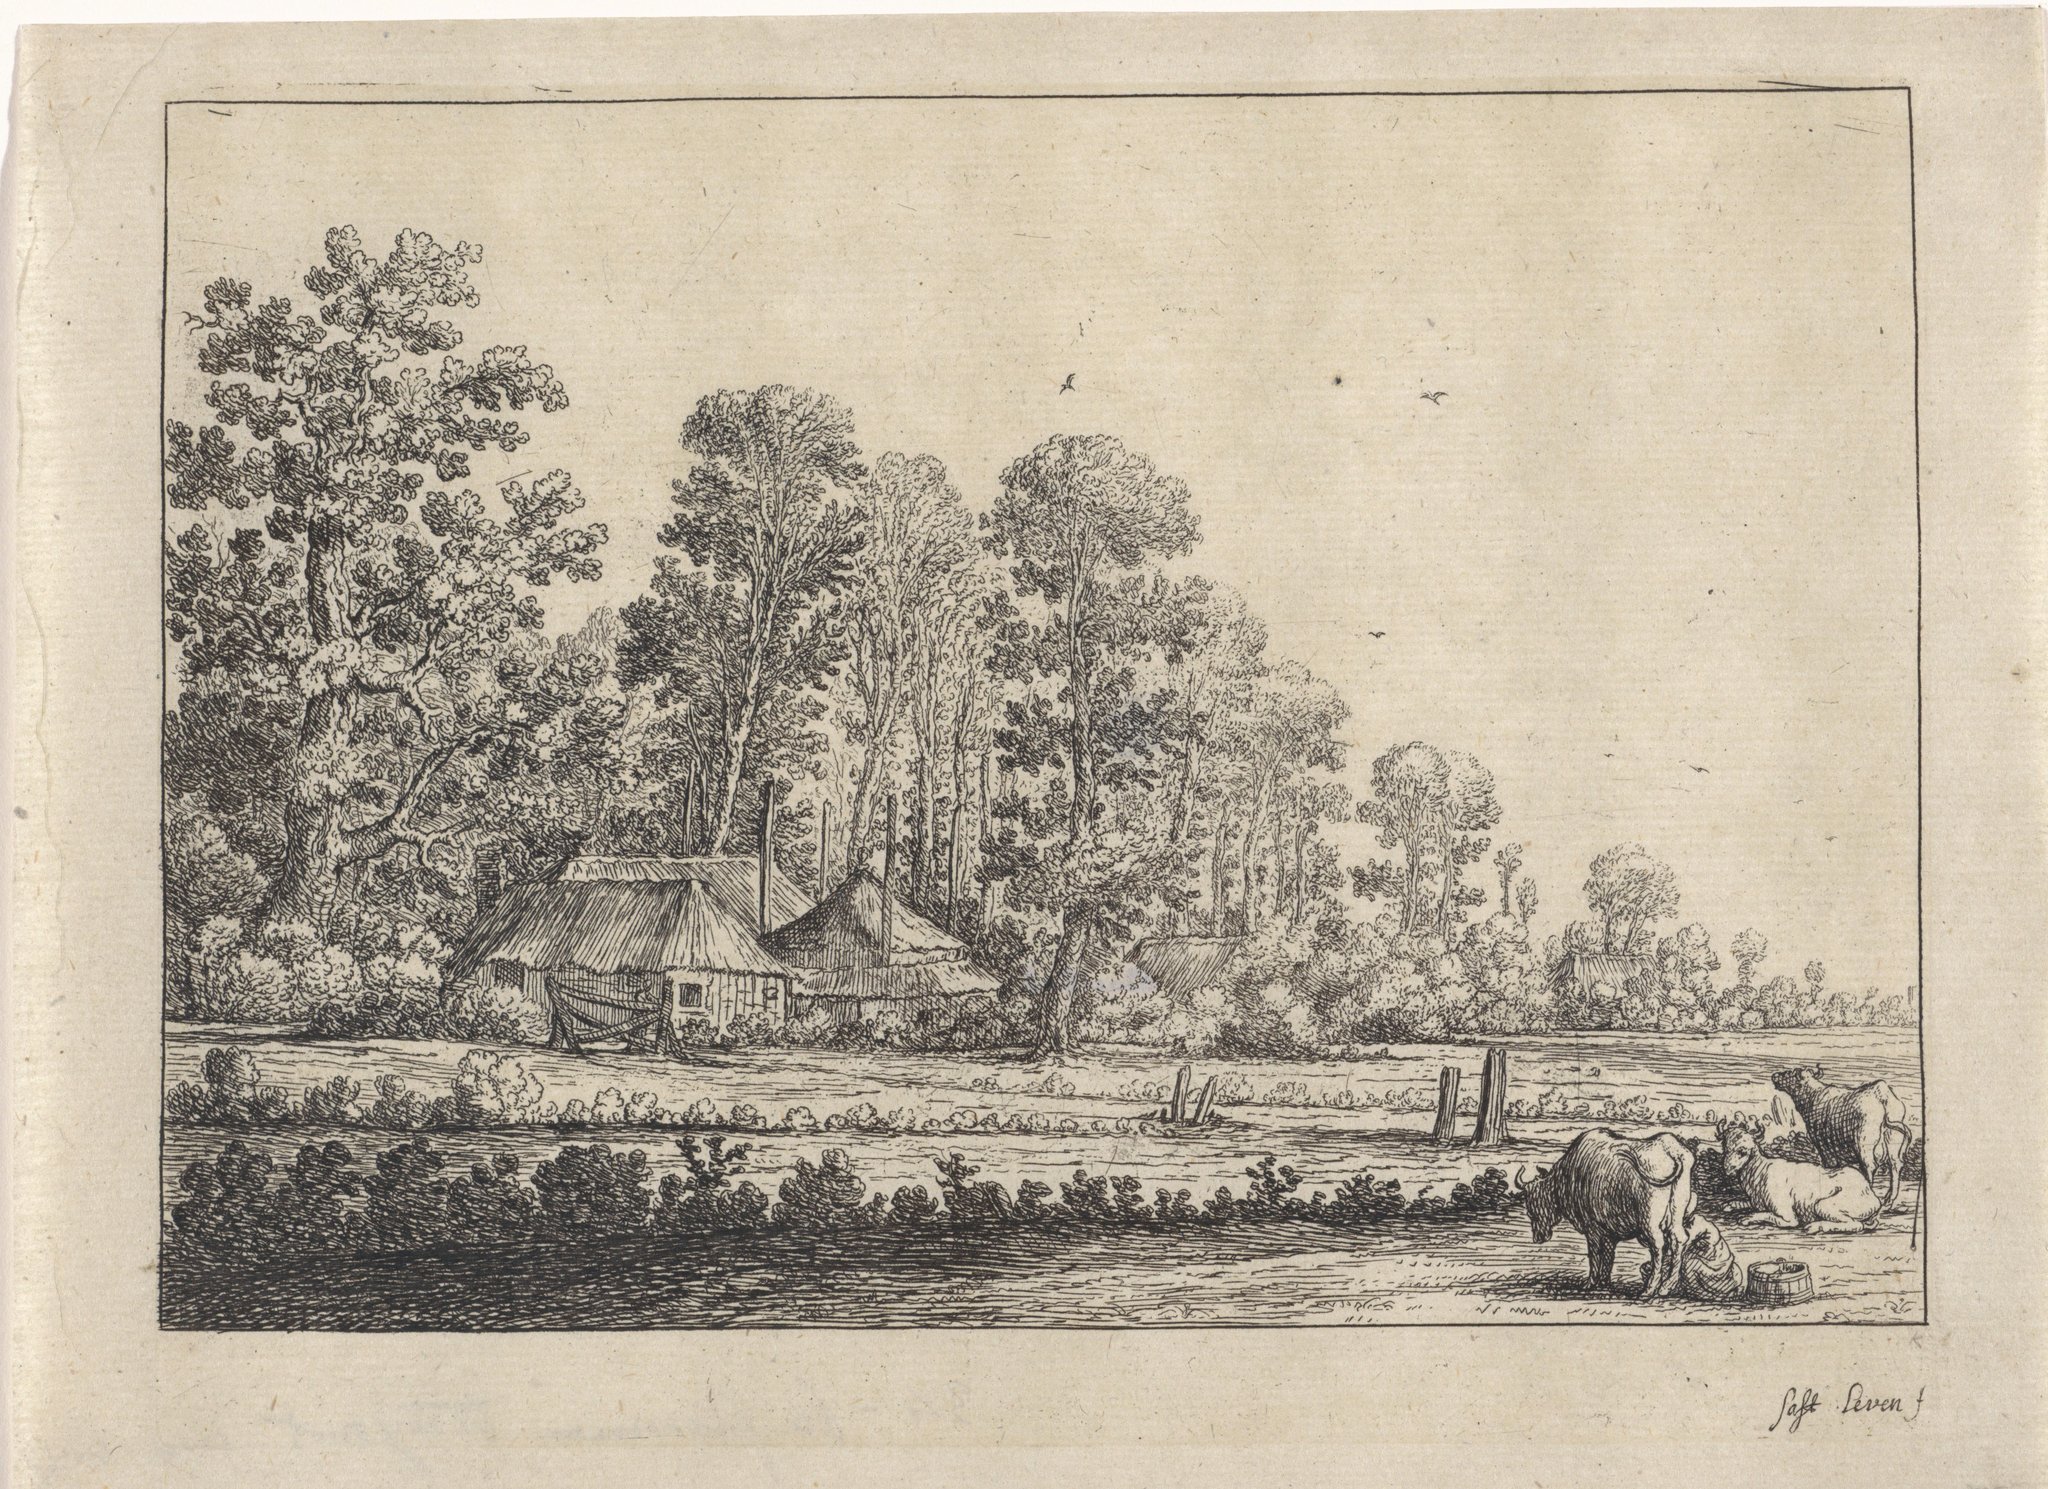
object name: print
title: Boerderij met koeienmelkster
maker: herman saftleven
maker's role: draughtsman, painter, print maker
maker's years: 1609-1685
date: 1626-1685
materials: paper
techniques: etching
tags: cow, river, bovine cattle, farm (building)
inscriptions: collector's mark: Lugt 2228, collector's mark: Lugt 2760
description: Gezicht op een vlak landschap met op de voorgrond een weide met drie koeien, waarvan er één gemolken wordt. Op de achtergrond liggen boerderijen aan de bosrand.